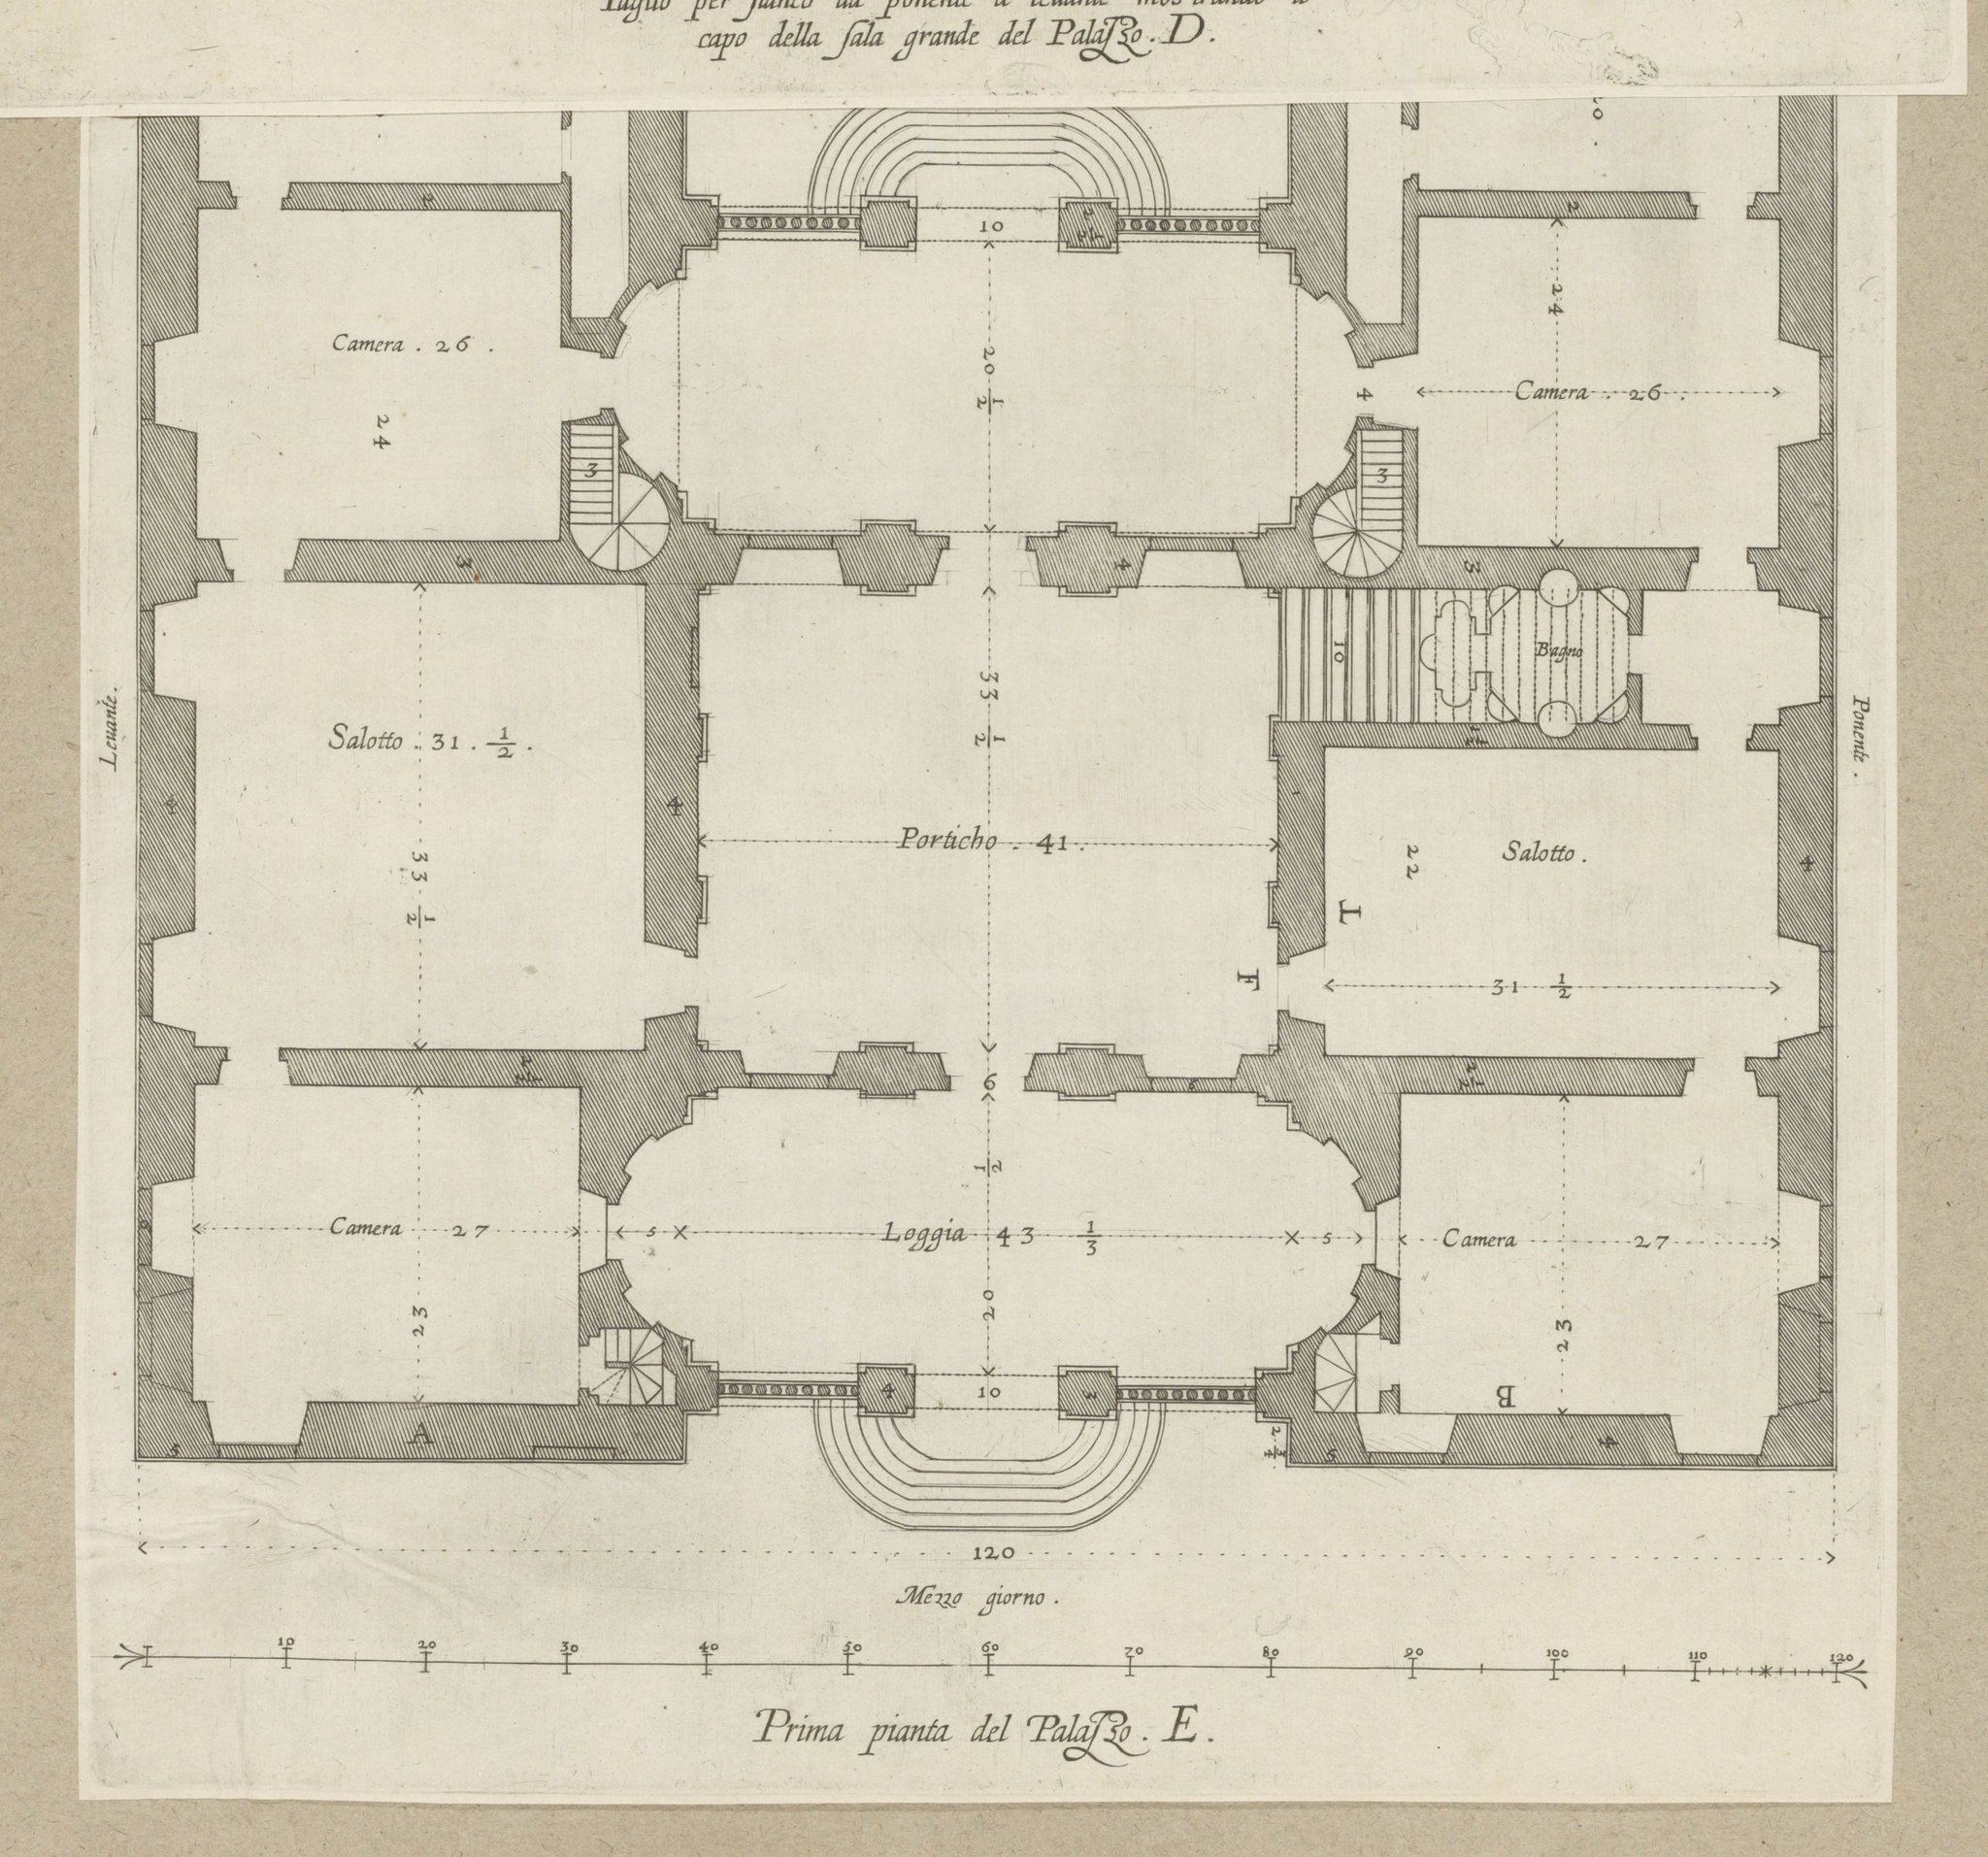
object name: print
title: Prima pianta del Palazzo. E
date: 1622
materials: paper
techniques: engraving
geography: antwerp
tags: hôtel, i.e. small palace in city - aa - civic architecture: inside, plan ~ architecture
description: Deze prent maakt deel uit van een album.